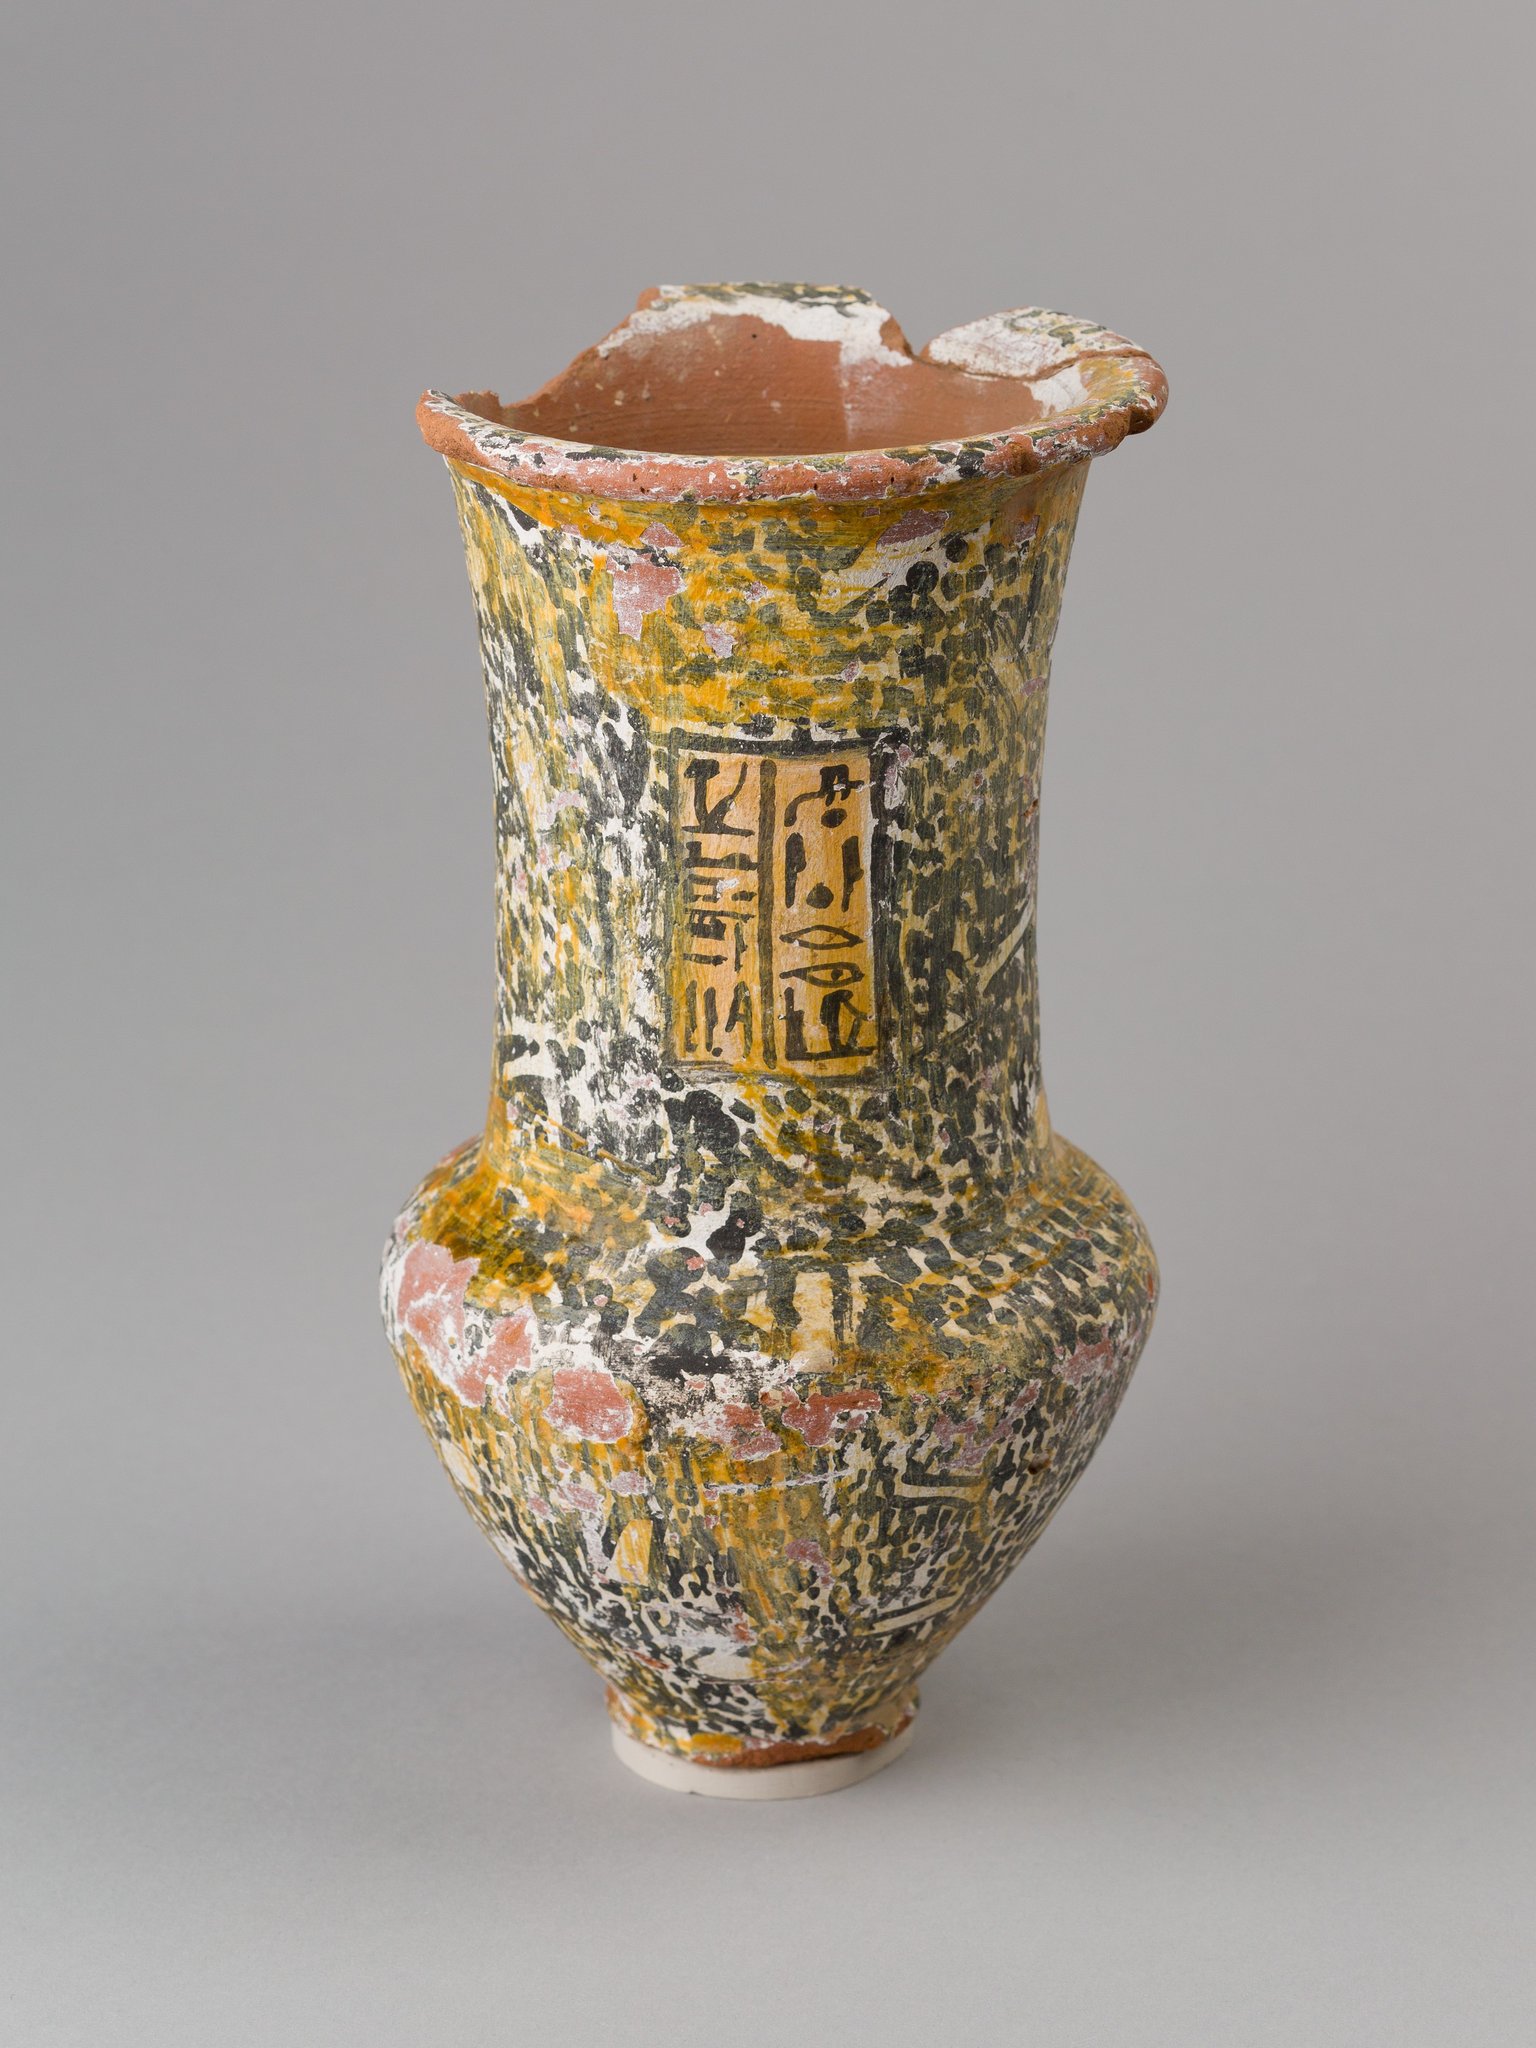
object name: jar, mery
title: Open-mouth Jar Inscribed for the Storehouse-Keeper of Amun Mery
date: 1479-1390 BCE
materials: paint, pottery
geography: upper egypt, thebes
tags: hieroglyphs